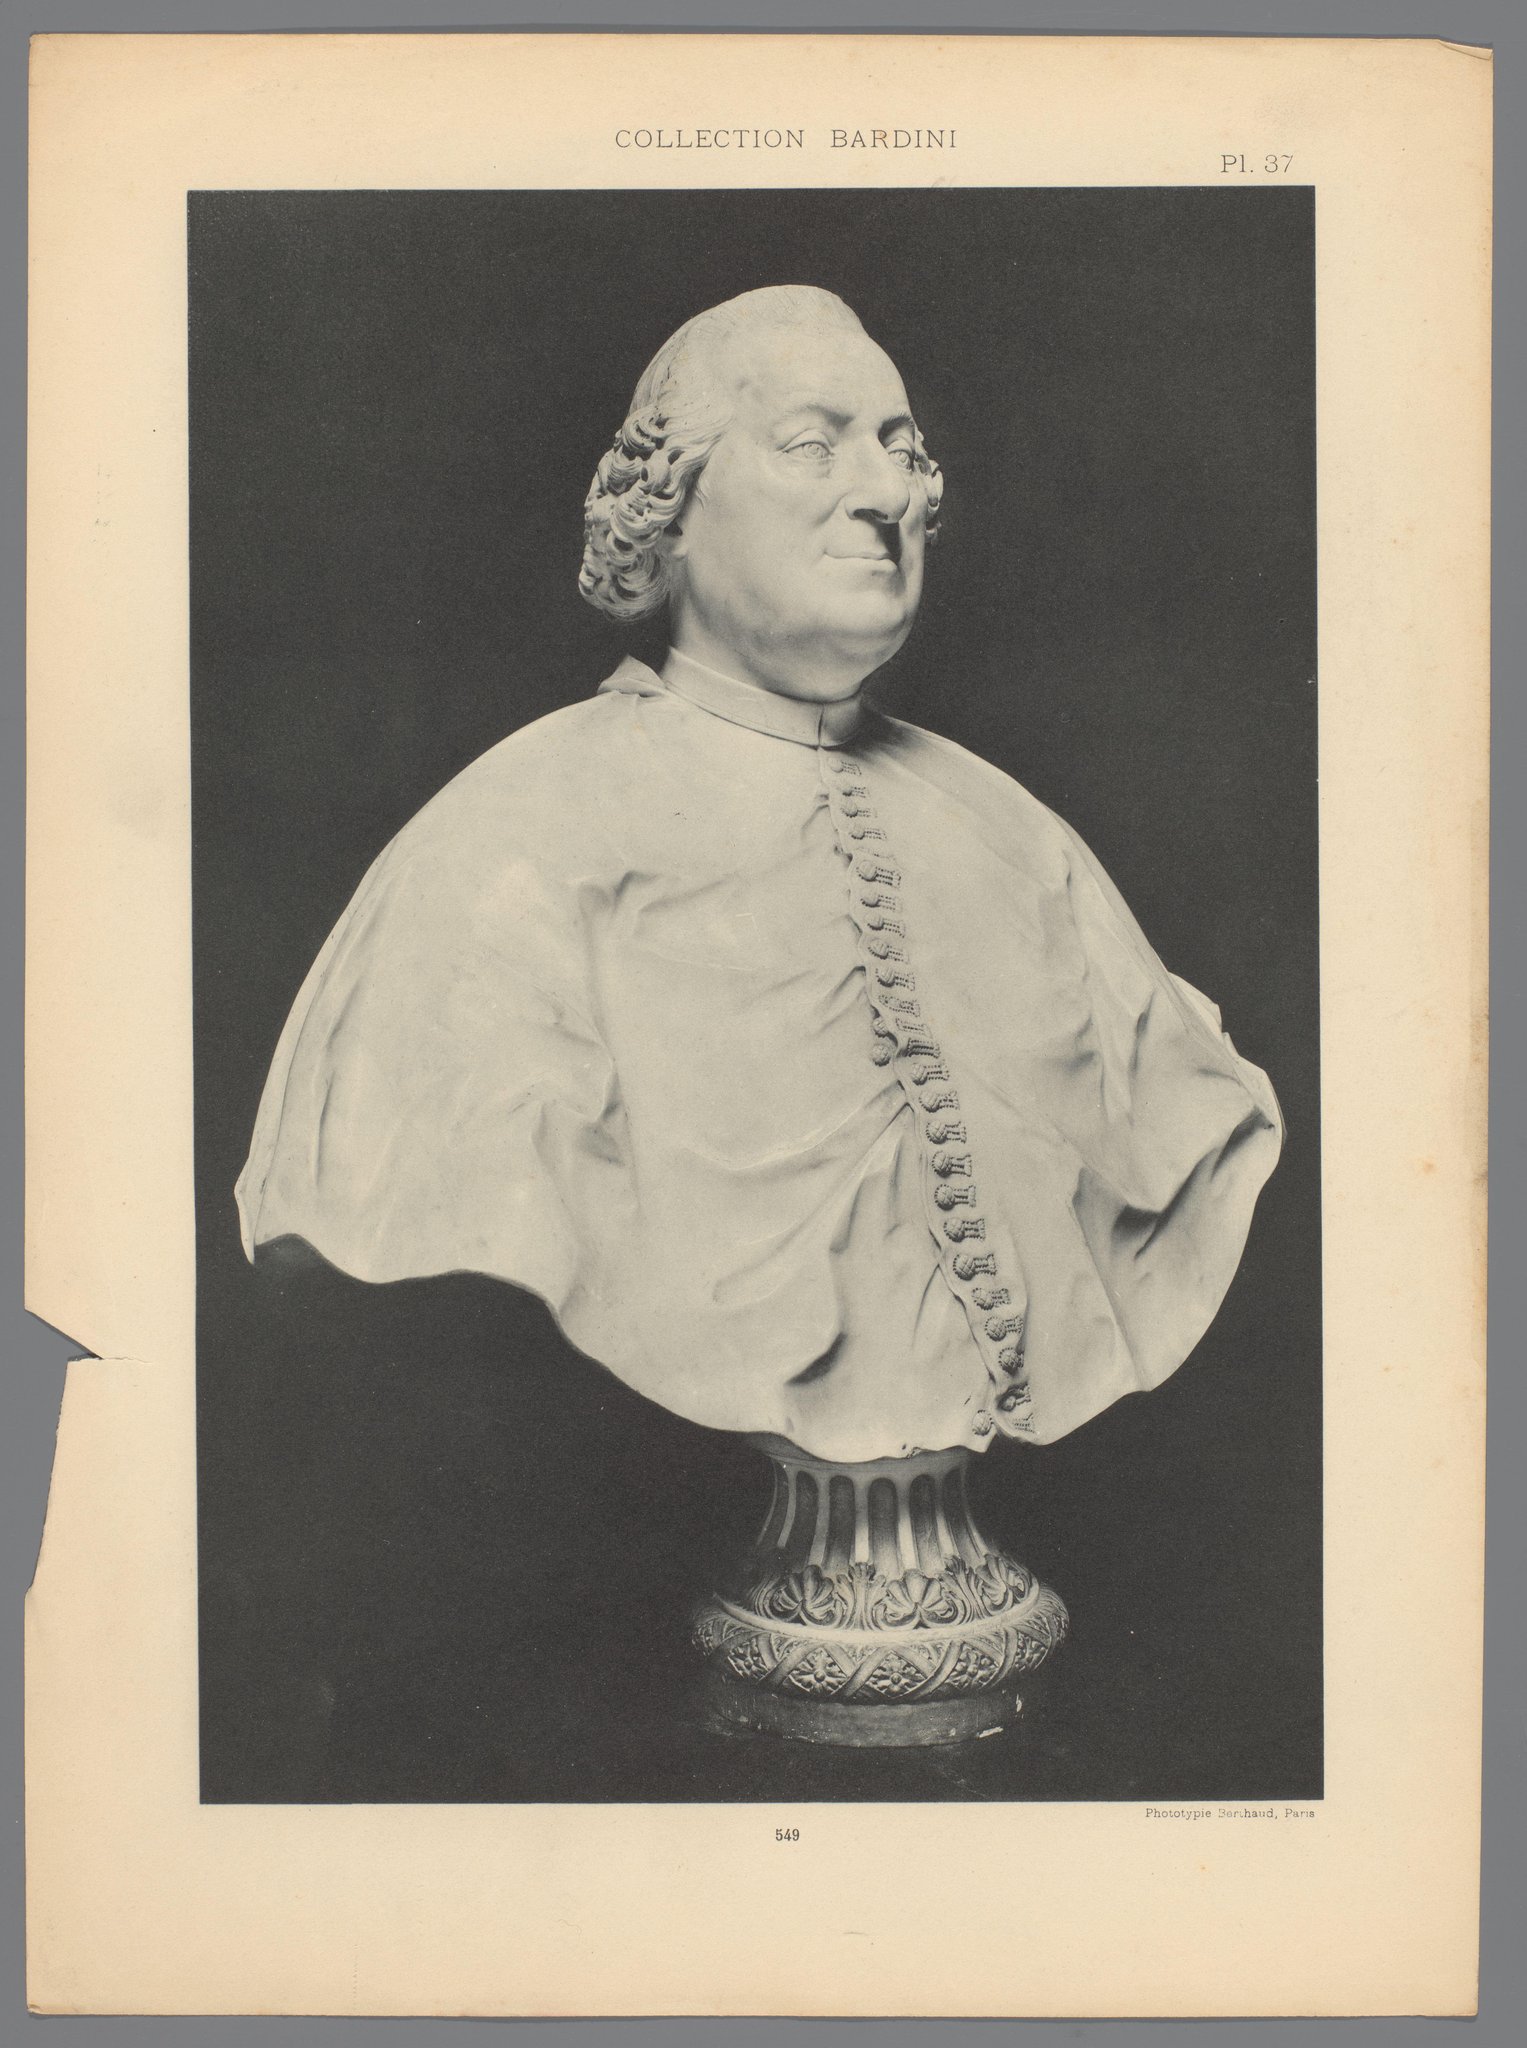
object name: photomechanical print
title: Collection Bardini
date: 1875-1912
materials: paper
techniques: photograph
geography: florence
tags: anonymous historical person portrayed, sculpture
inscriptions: number: ‘Pl. 37’